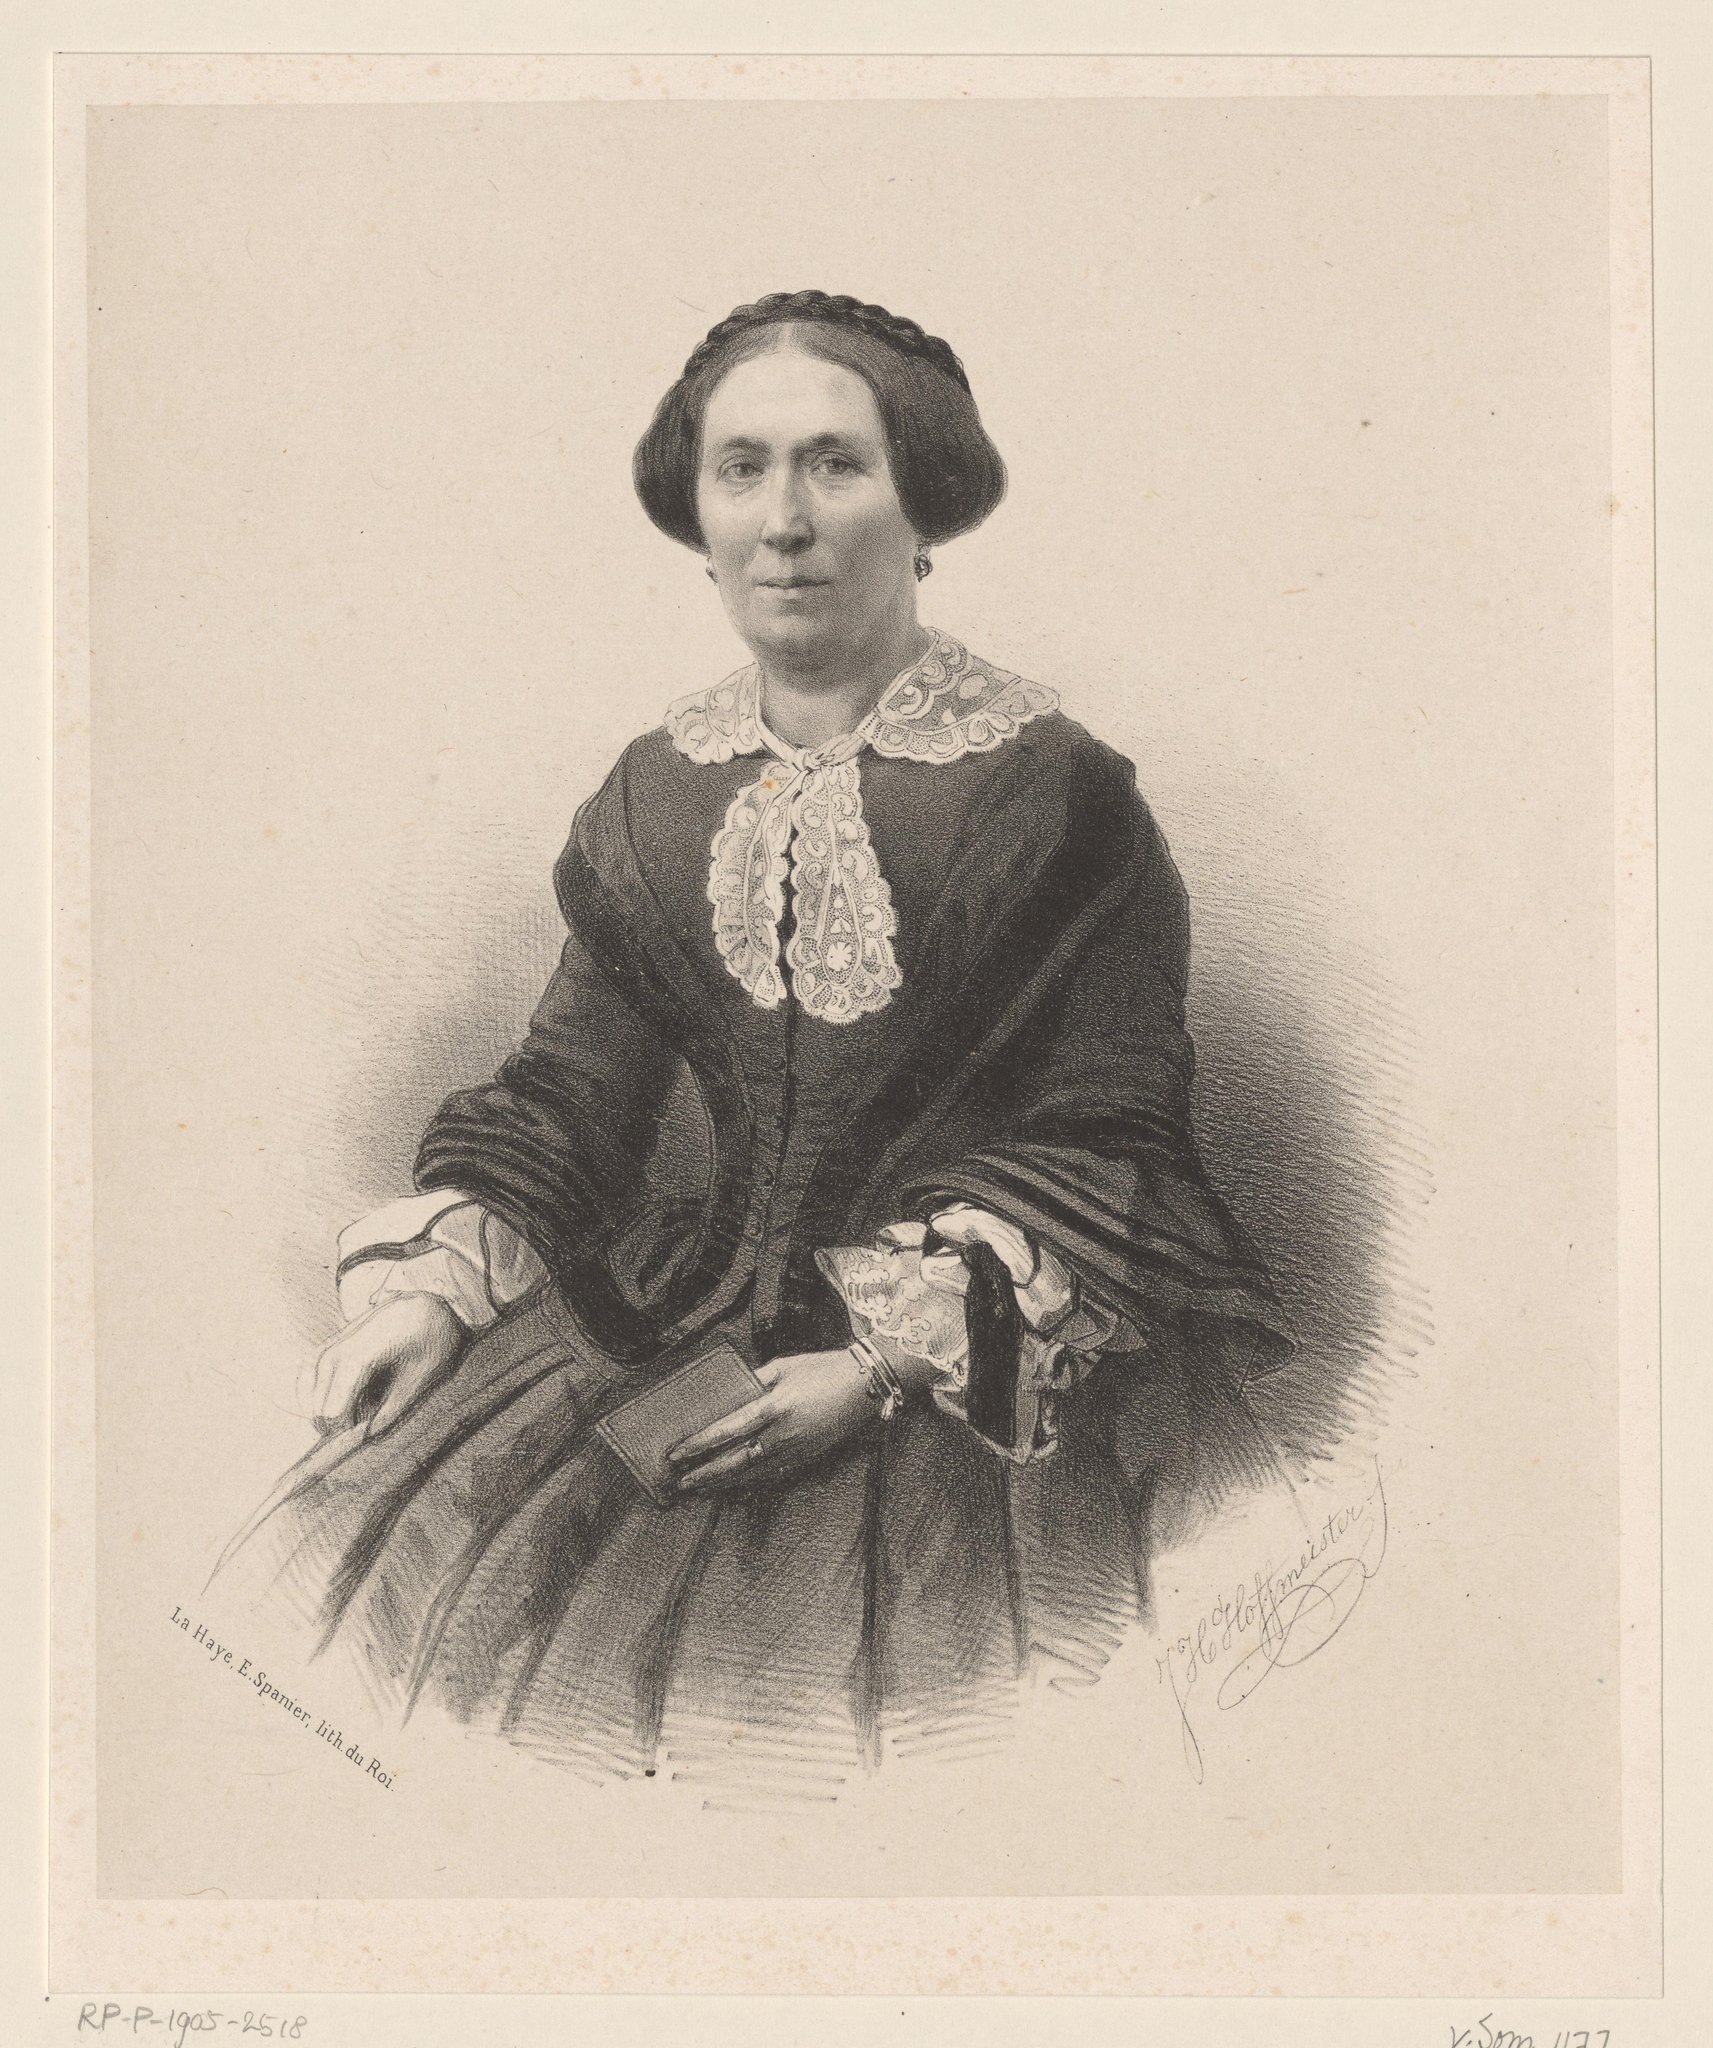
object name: print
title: Portret van Wilhelmina Brosterhuijzen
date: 1843-1863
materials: paper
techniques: lithograph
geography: the hague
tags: historical persons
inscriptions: collector's mark: Lugt 2228